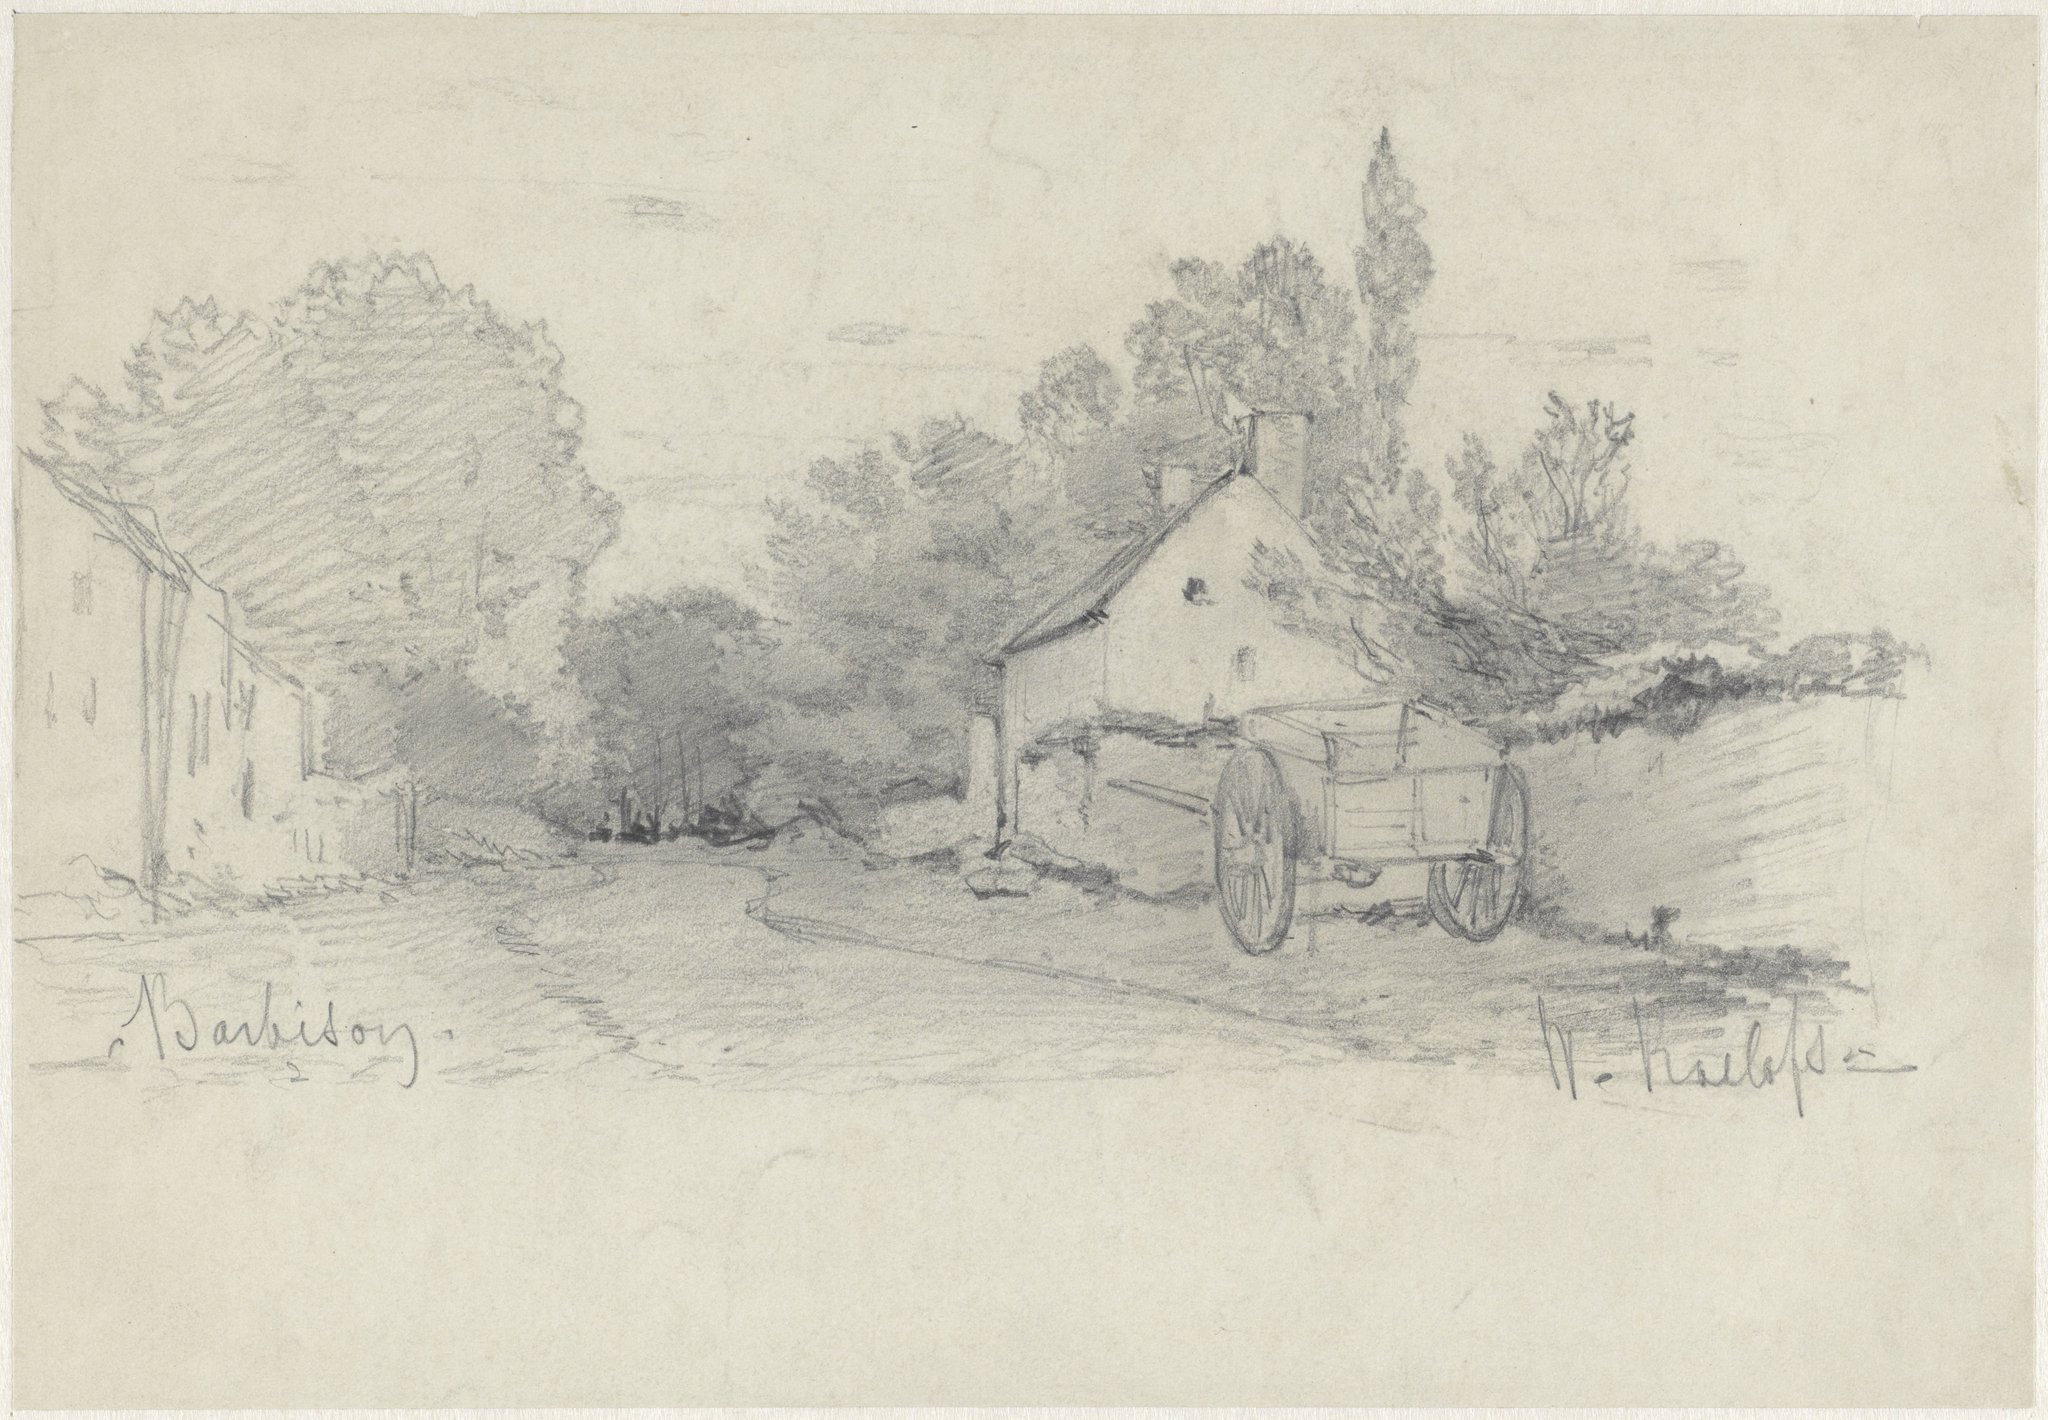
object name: drawing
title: Gezicht op een straatje met een kar in Barbizon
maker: willem roelofs (i)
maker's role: draughtsman, painter, print maker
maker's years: 1822-1897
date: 1832-1897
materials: paper, pencil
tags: village street